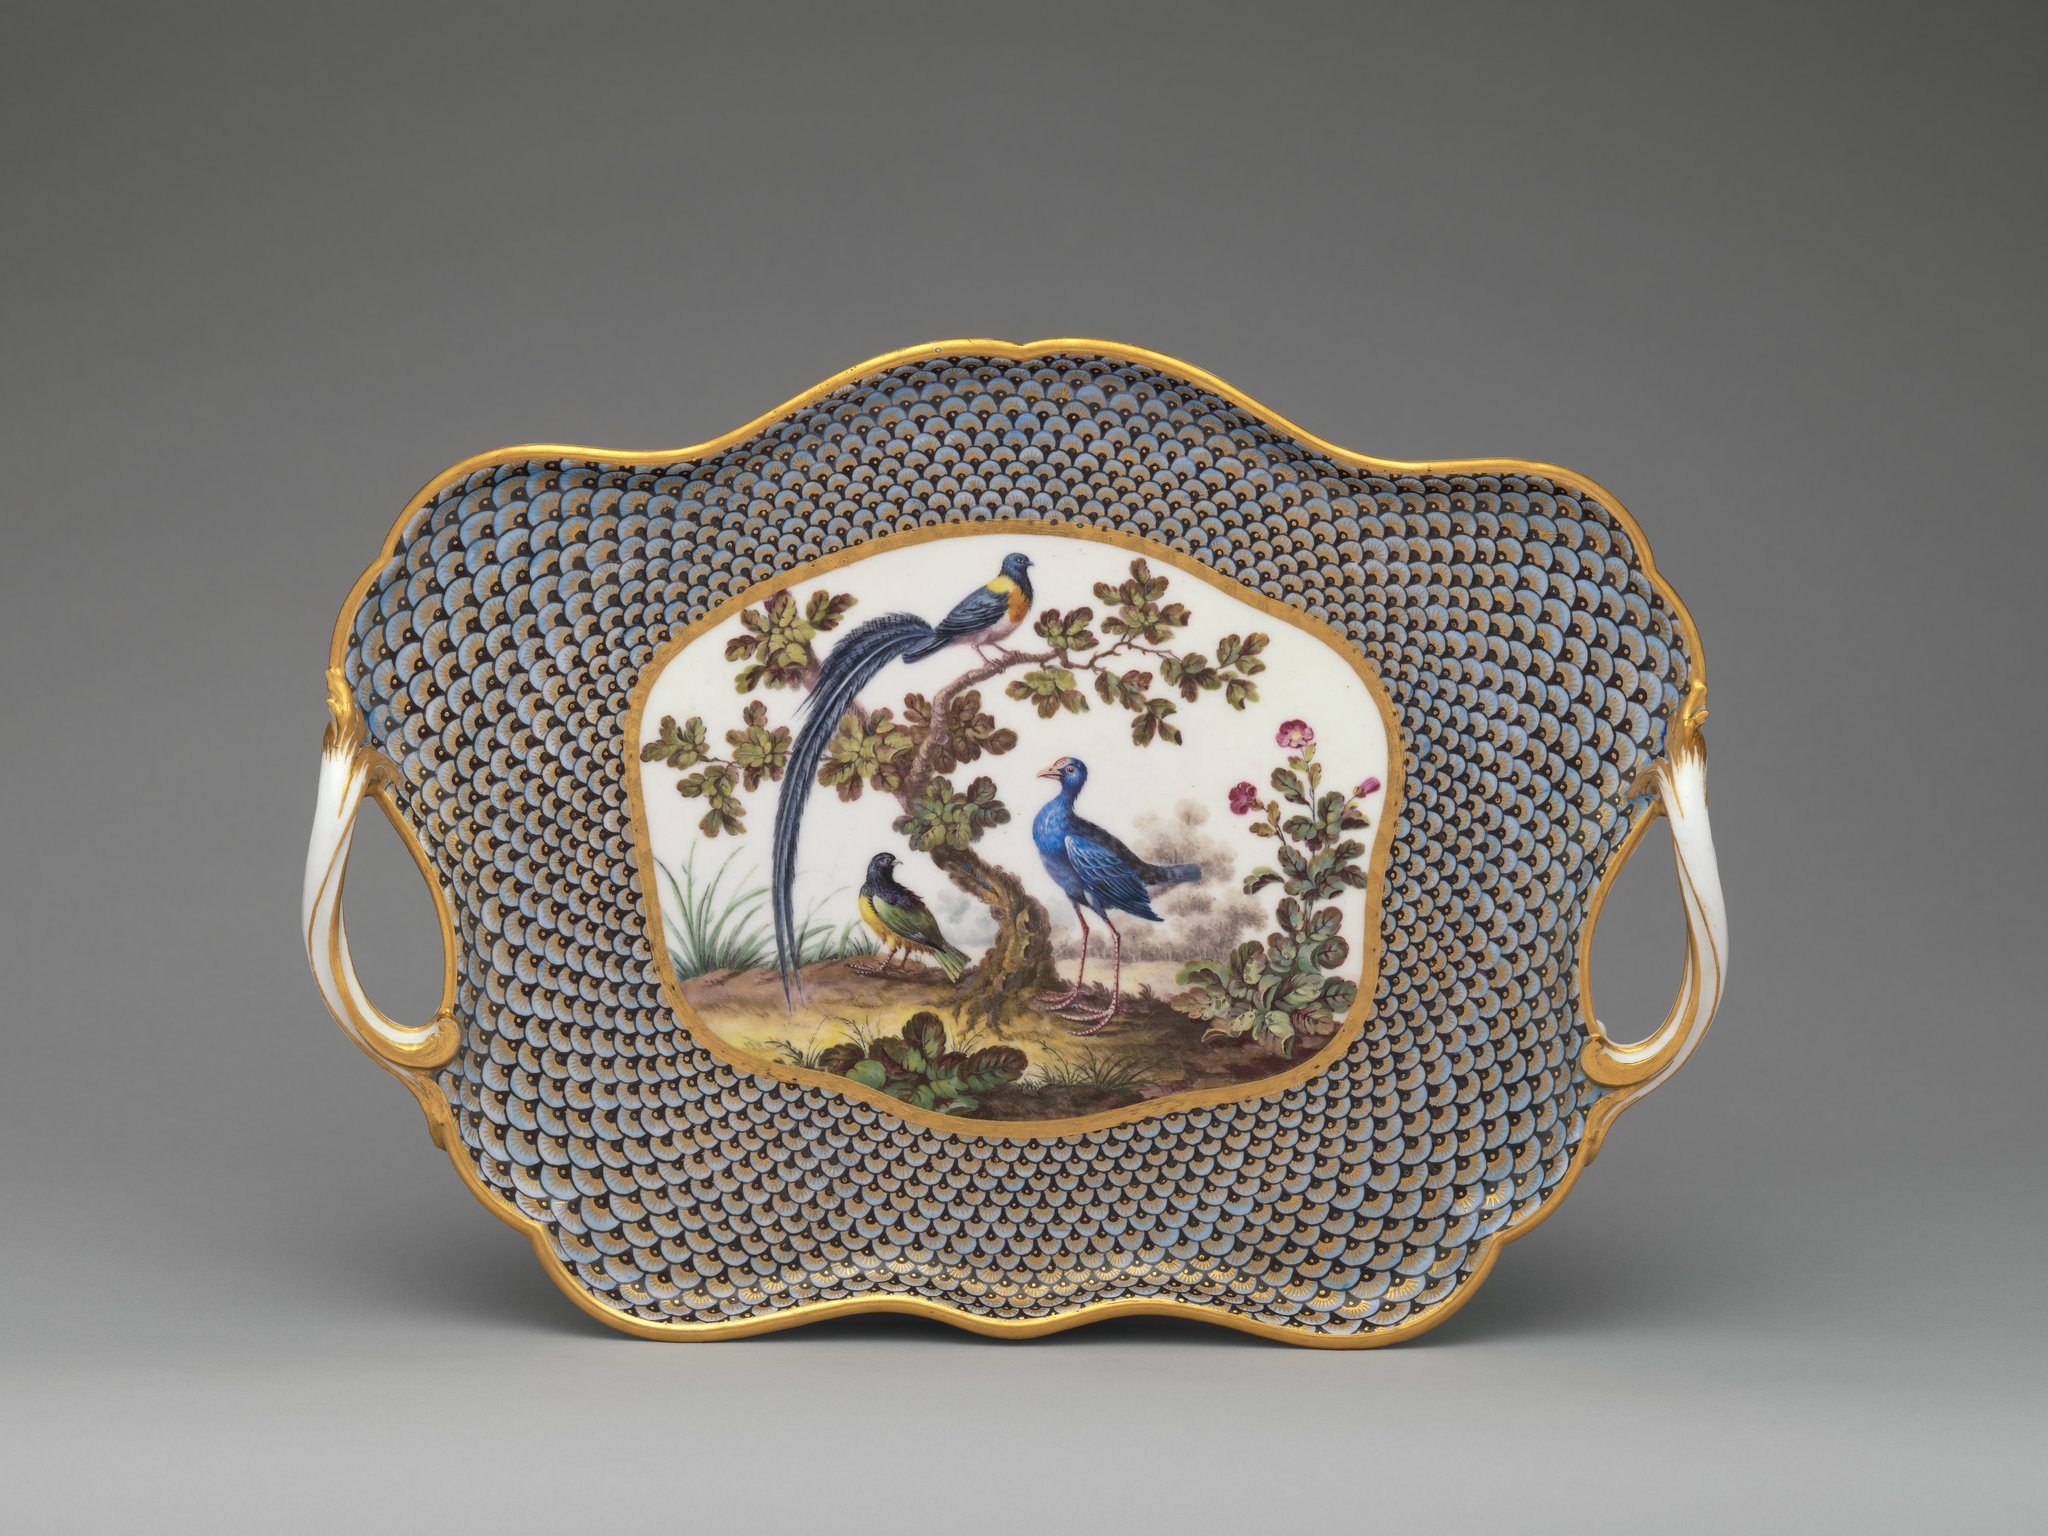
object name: tray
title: Tray (plateau Duplessis) (part of a service)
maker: sèvres manufactory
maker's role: manufactory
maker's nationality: french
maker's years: 1740-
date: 1767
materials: enamel, gold, soft paste porcelain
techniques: polychrome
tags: birds